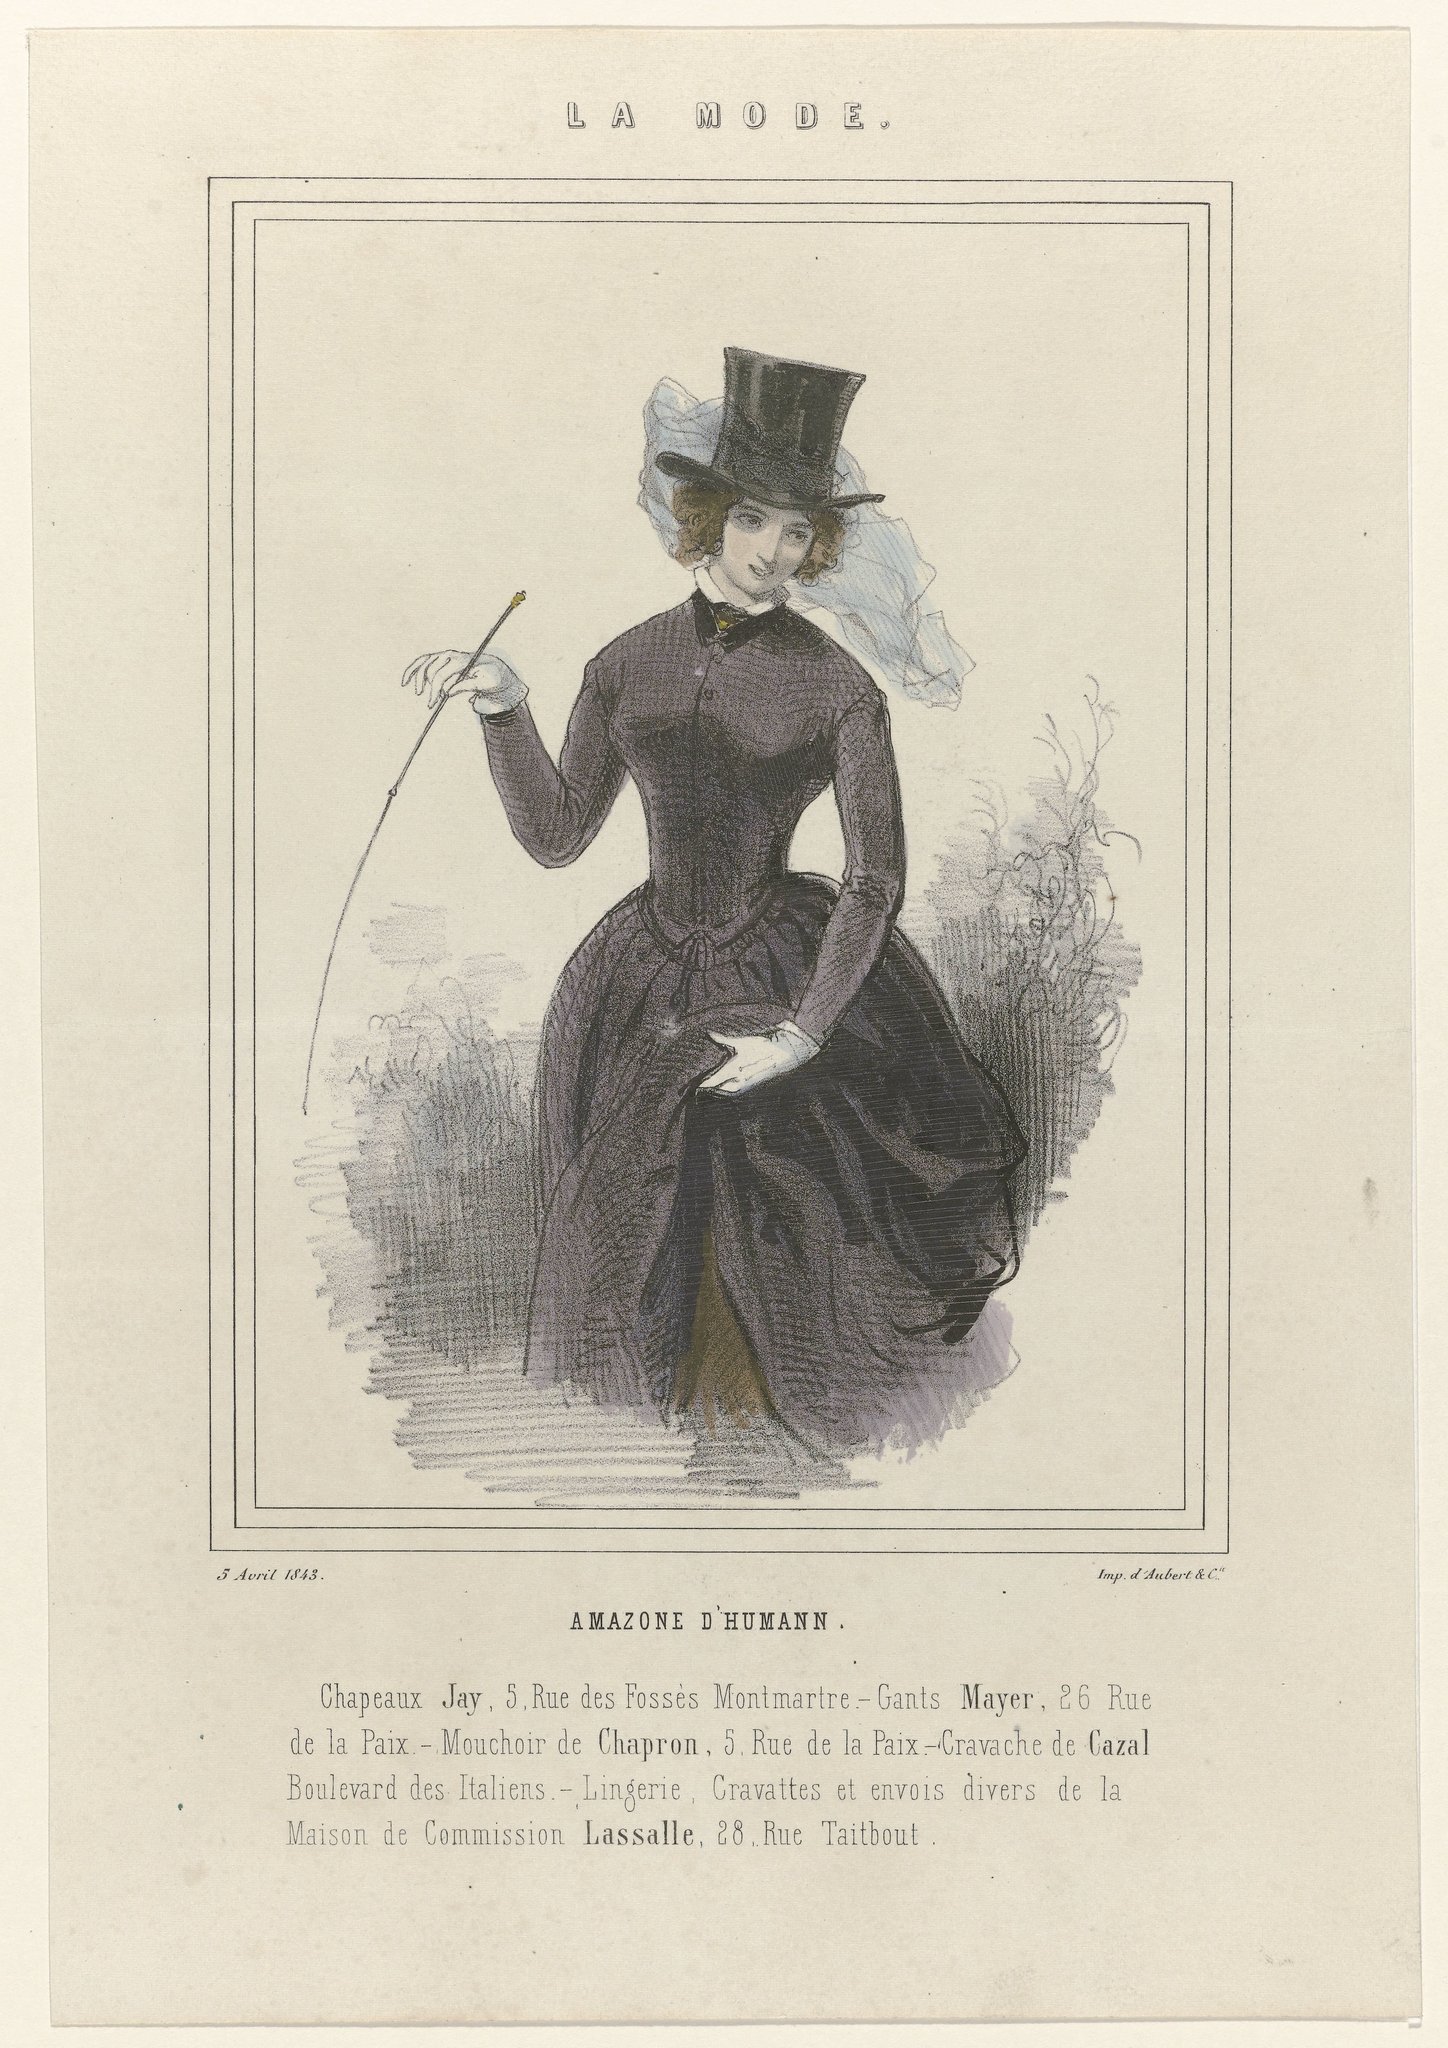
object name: fashion print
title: La Mode, 5 avril 1843 : Amazone d'Humann (...)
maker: Anonymous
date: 1843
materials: paper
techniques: hand coloring, lithograph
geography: paris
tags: riding a horse, ass, or mule; rider, horseman (+ variant), clothing for the upper part of the body (+ women's clothes), veil (+ women's clothes), gloves, mittens (short gloves) (+ women's clothes), fashion plates, skirt (+ women's clothes), whip, ensembles of pieces of clothing (riding costume) (+ women's clothes)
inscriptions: title: ‘La Mode.’, caption: ‘Amazone d'Humann. / Chapeaux Jay, 5 Rue des Fossès Montmartre.- Gants Mayer, 26 Rue de la Paix.- Mouchoir de Chapron, 5, Rue de la Paix. - Cravache de Cazal Boulevard des Italiens. - Lingerie, Cravattes et envois divers de la Maison de Commission Lassalle, 28, Rue Taitbout.’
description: Vrouw gekleed in een amazonekostuum (rijkostuum) van Humann. Op het hoofd een hoge hoed met sluier van Jay. Verdere accessoires: korte handschoenen van Mayer, zakdoek van Chapron, zweep van Cazal. Hieronder enkele regels reclametekst voor verschillende producten.